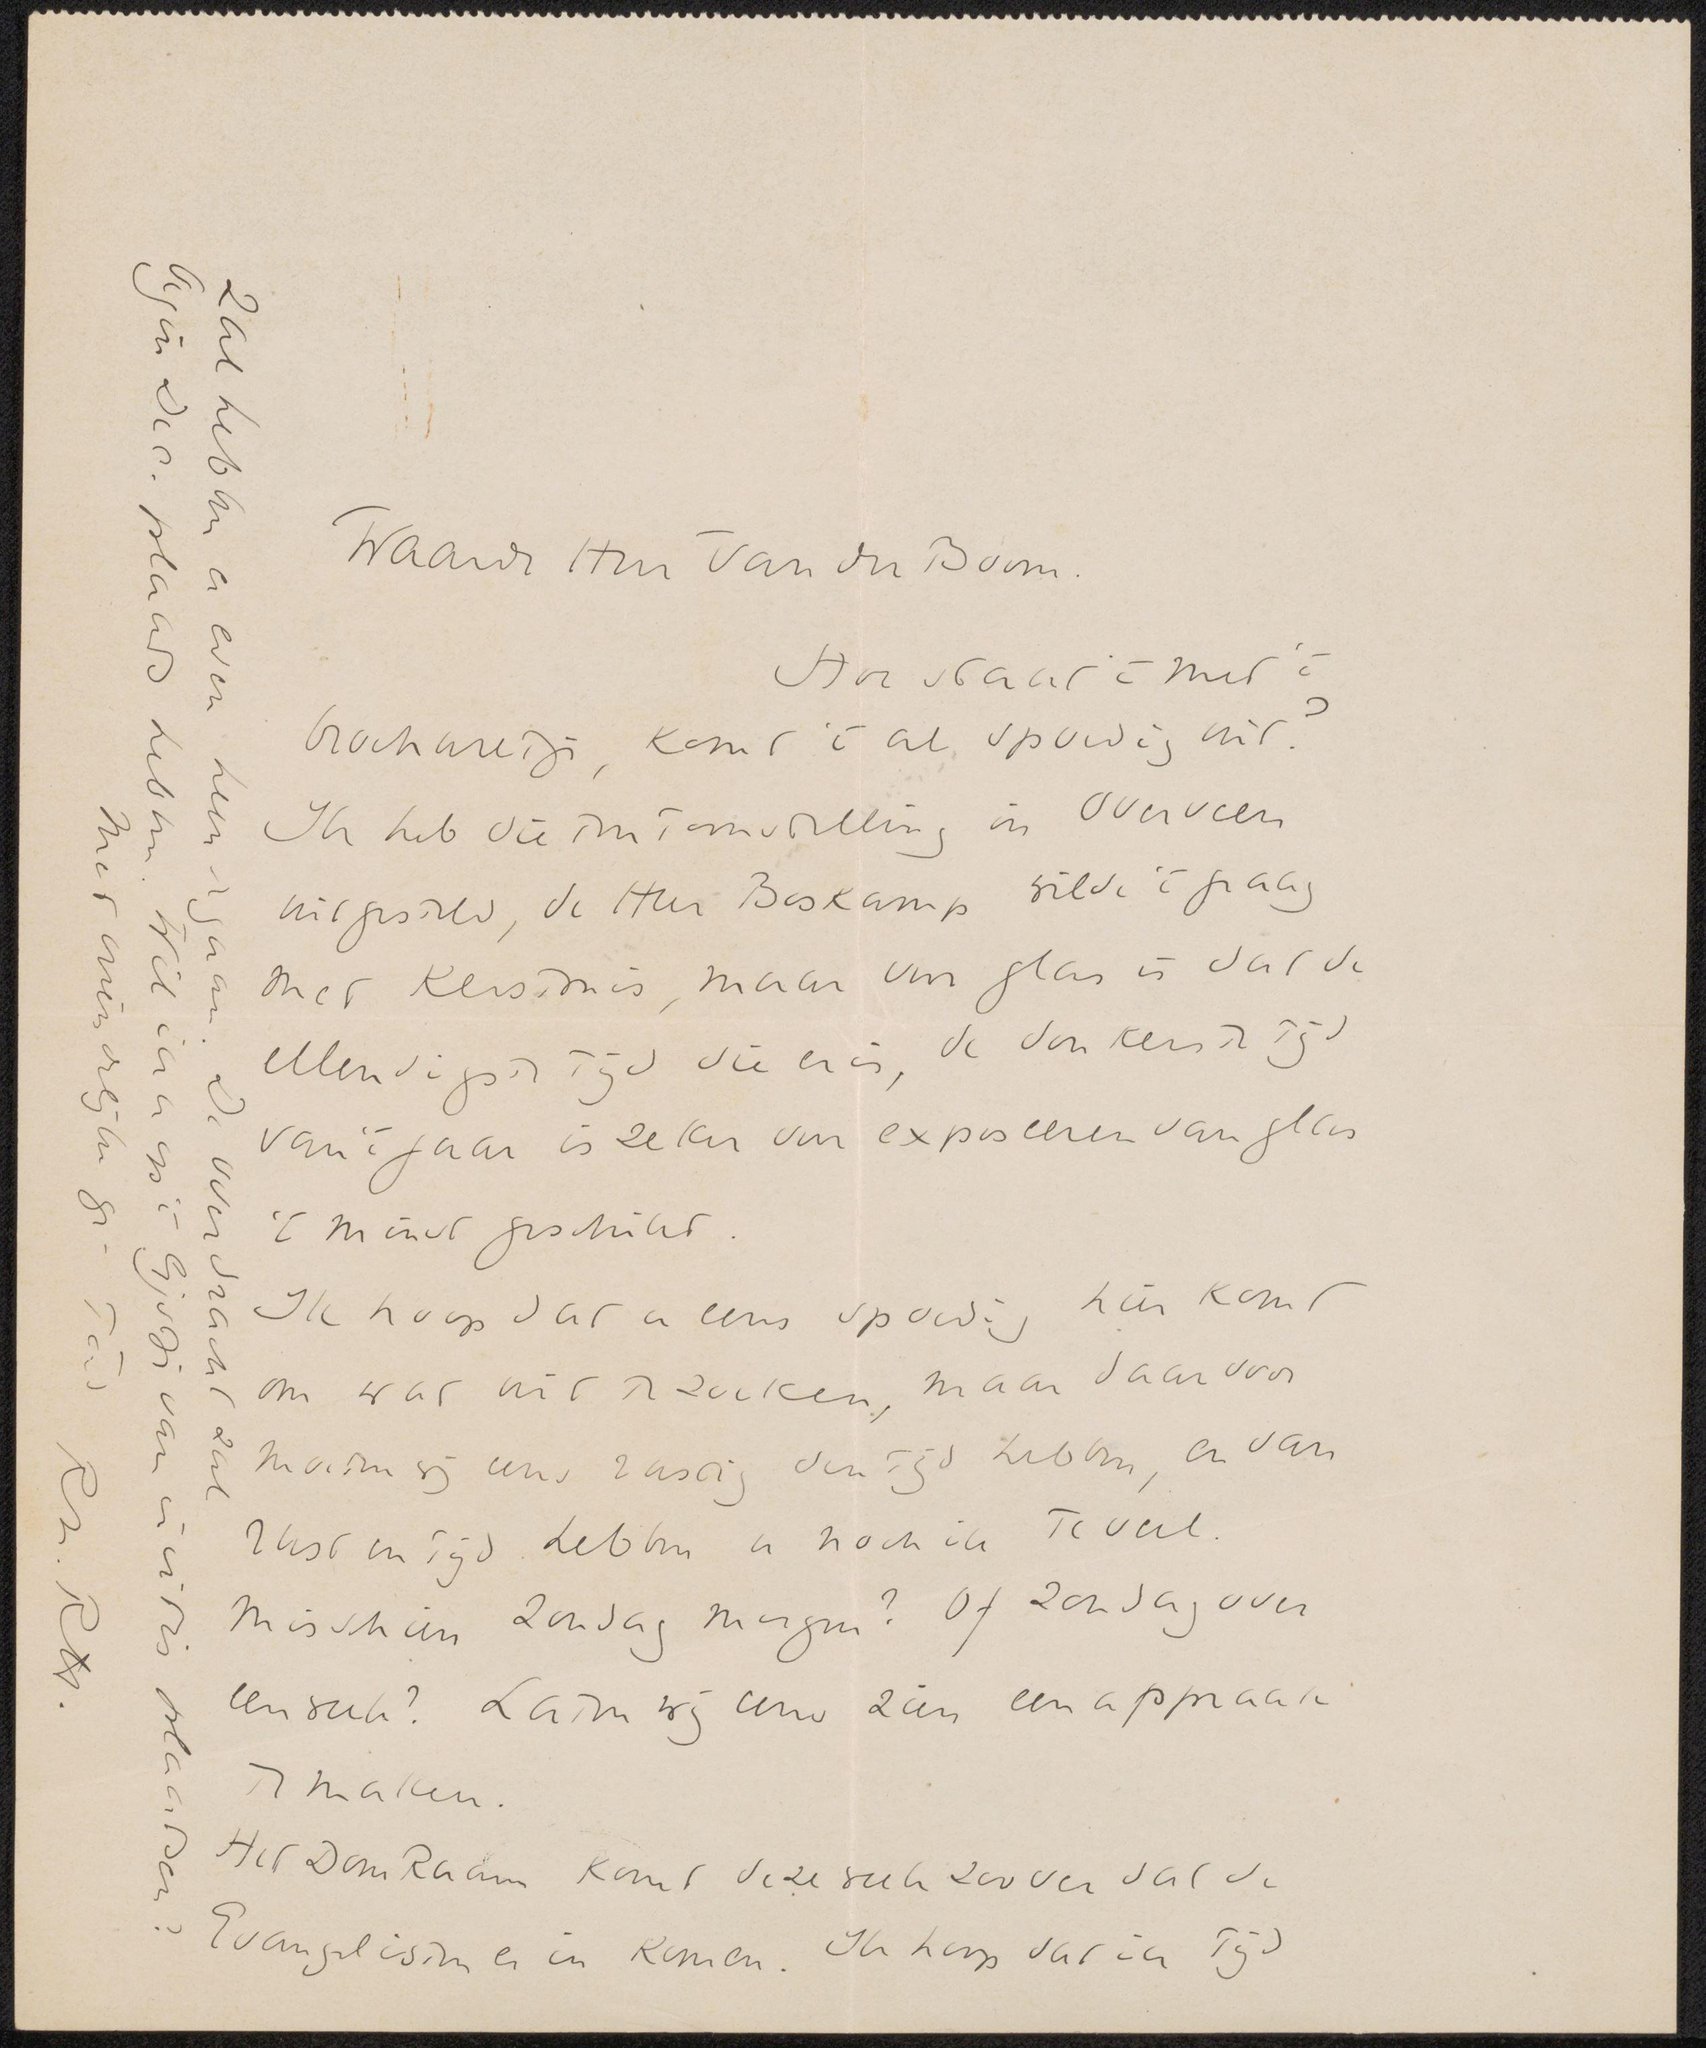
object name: letter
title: Brief aan A. van der Boom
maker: richard nicolaüs roland holst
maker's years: 1868-1938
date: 1923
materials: ink, paper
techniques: pen, writing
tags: a. van der boom, applied arts, arts and crafts; industrial design, exhibition ~ art, printed matter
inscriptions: collector's mark: Lugt L.2228a